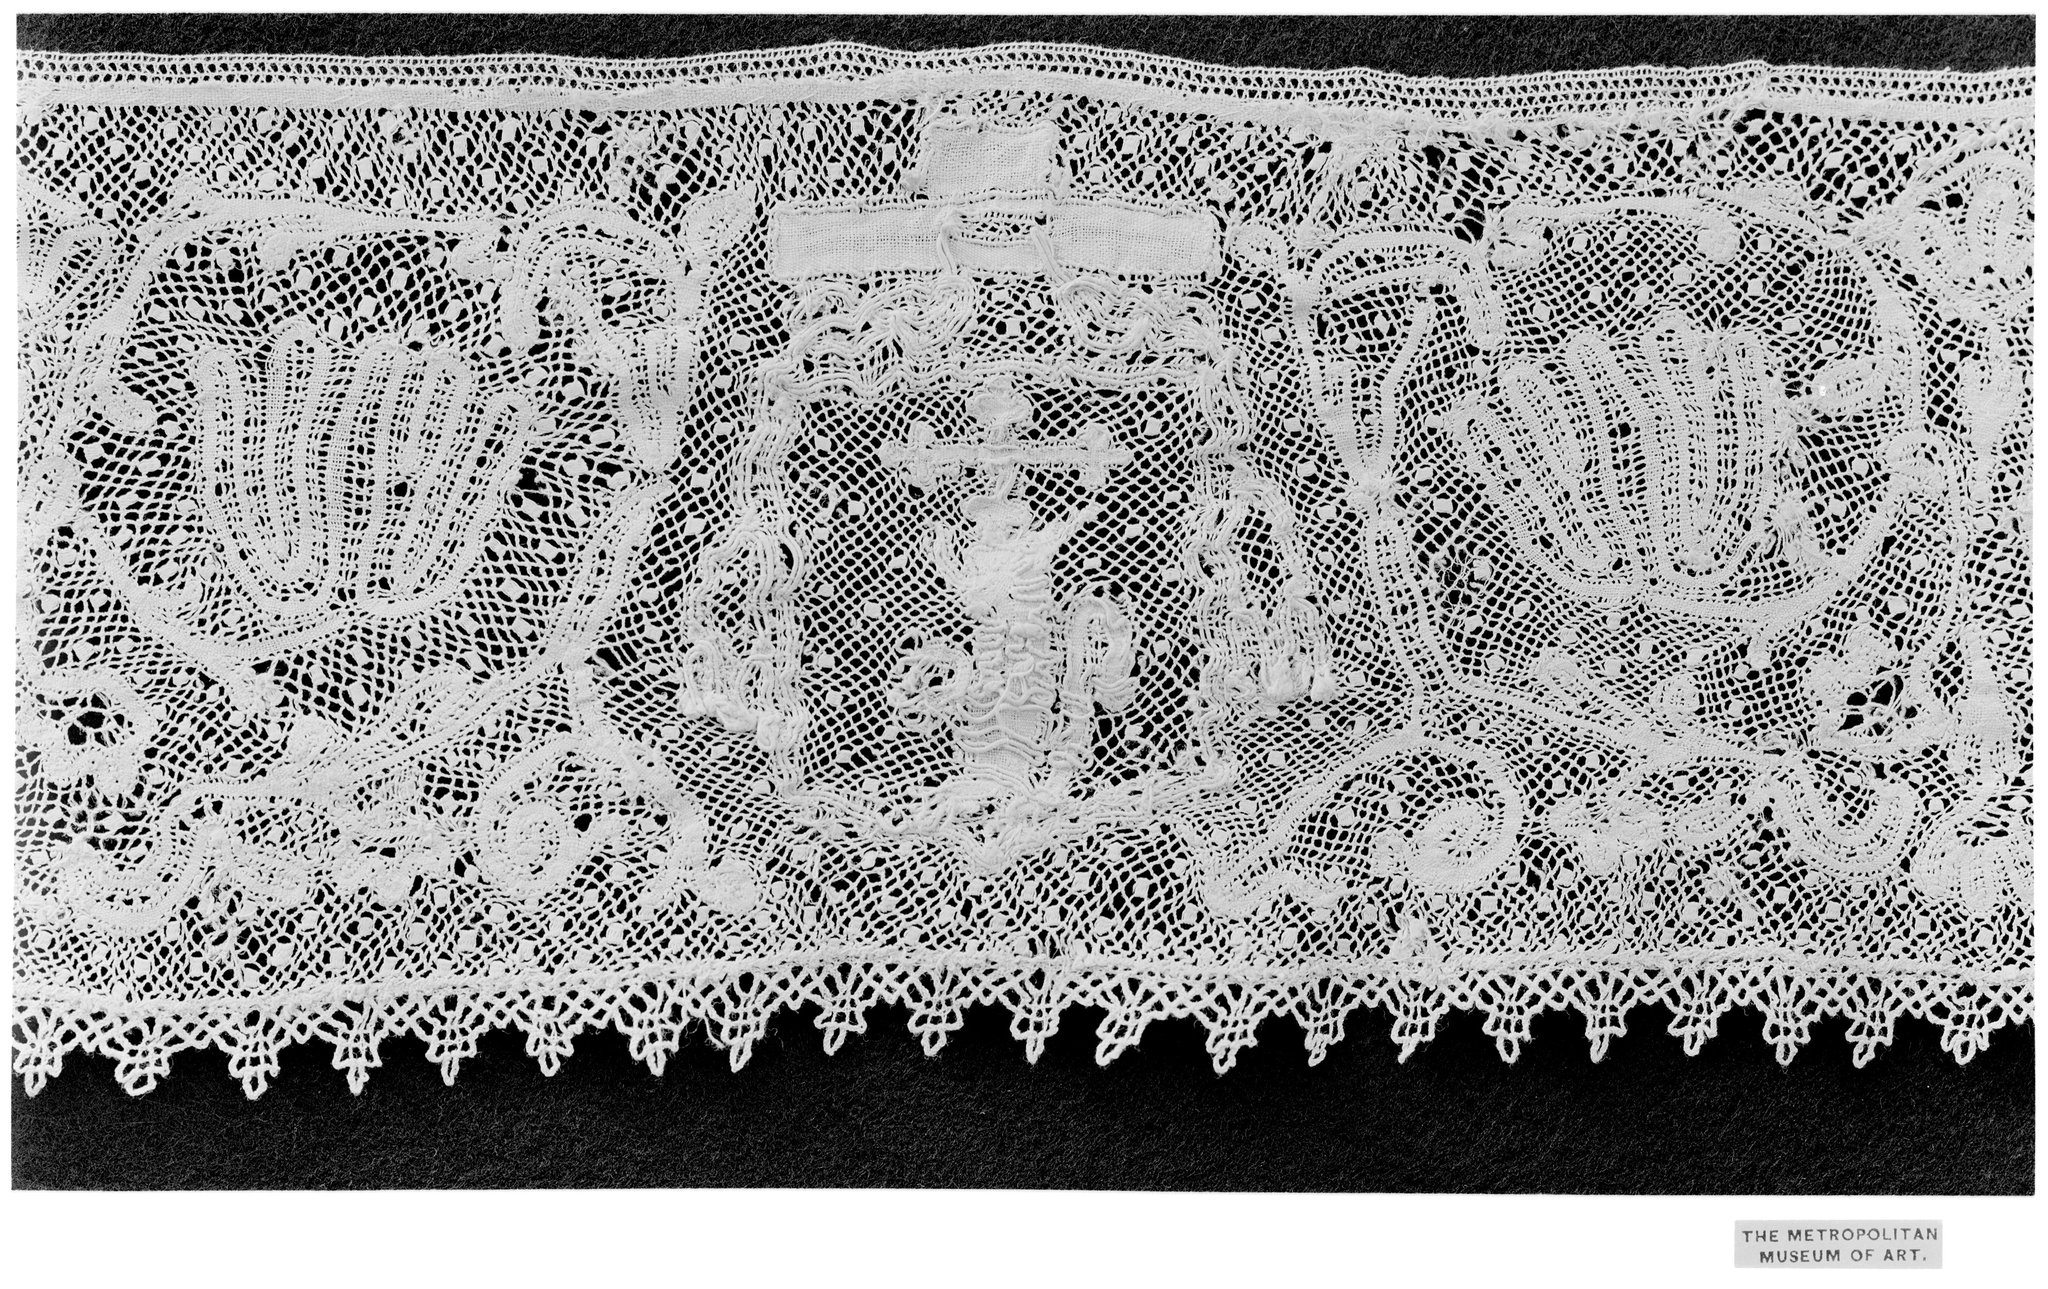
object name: border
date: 1601-1700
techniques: lace